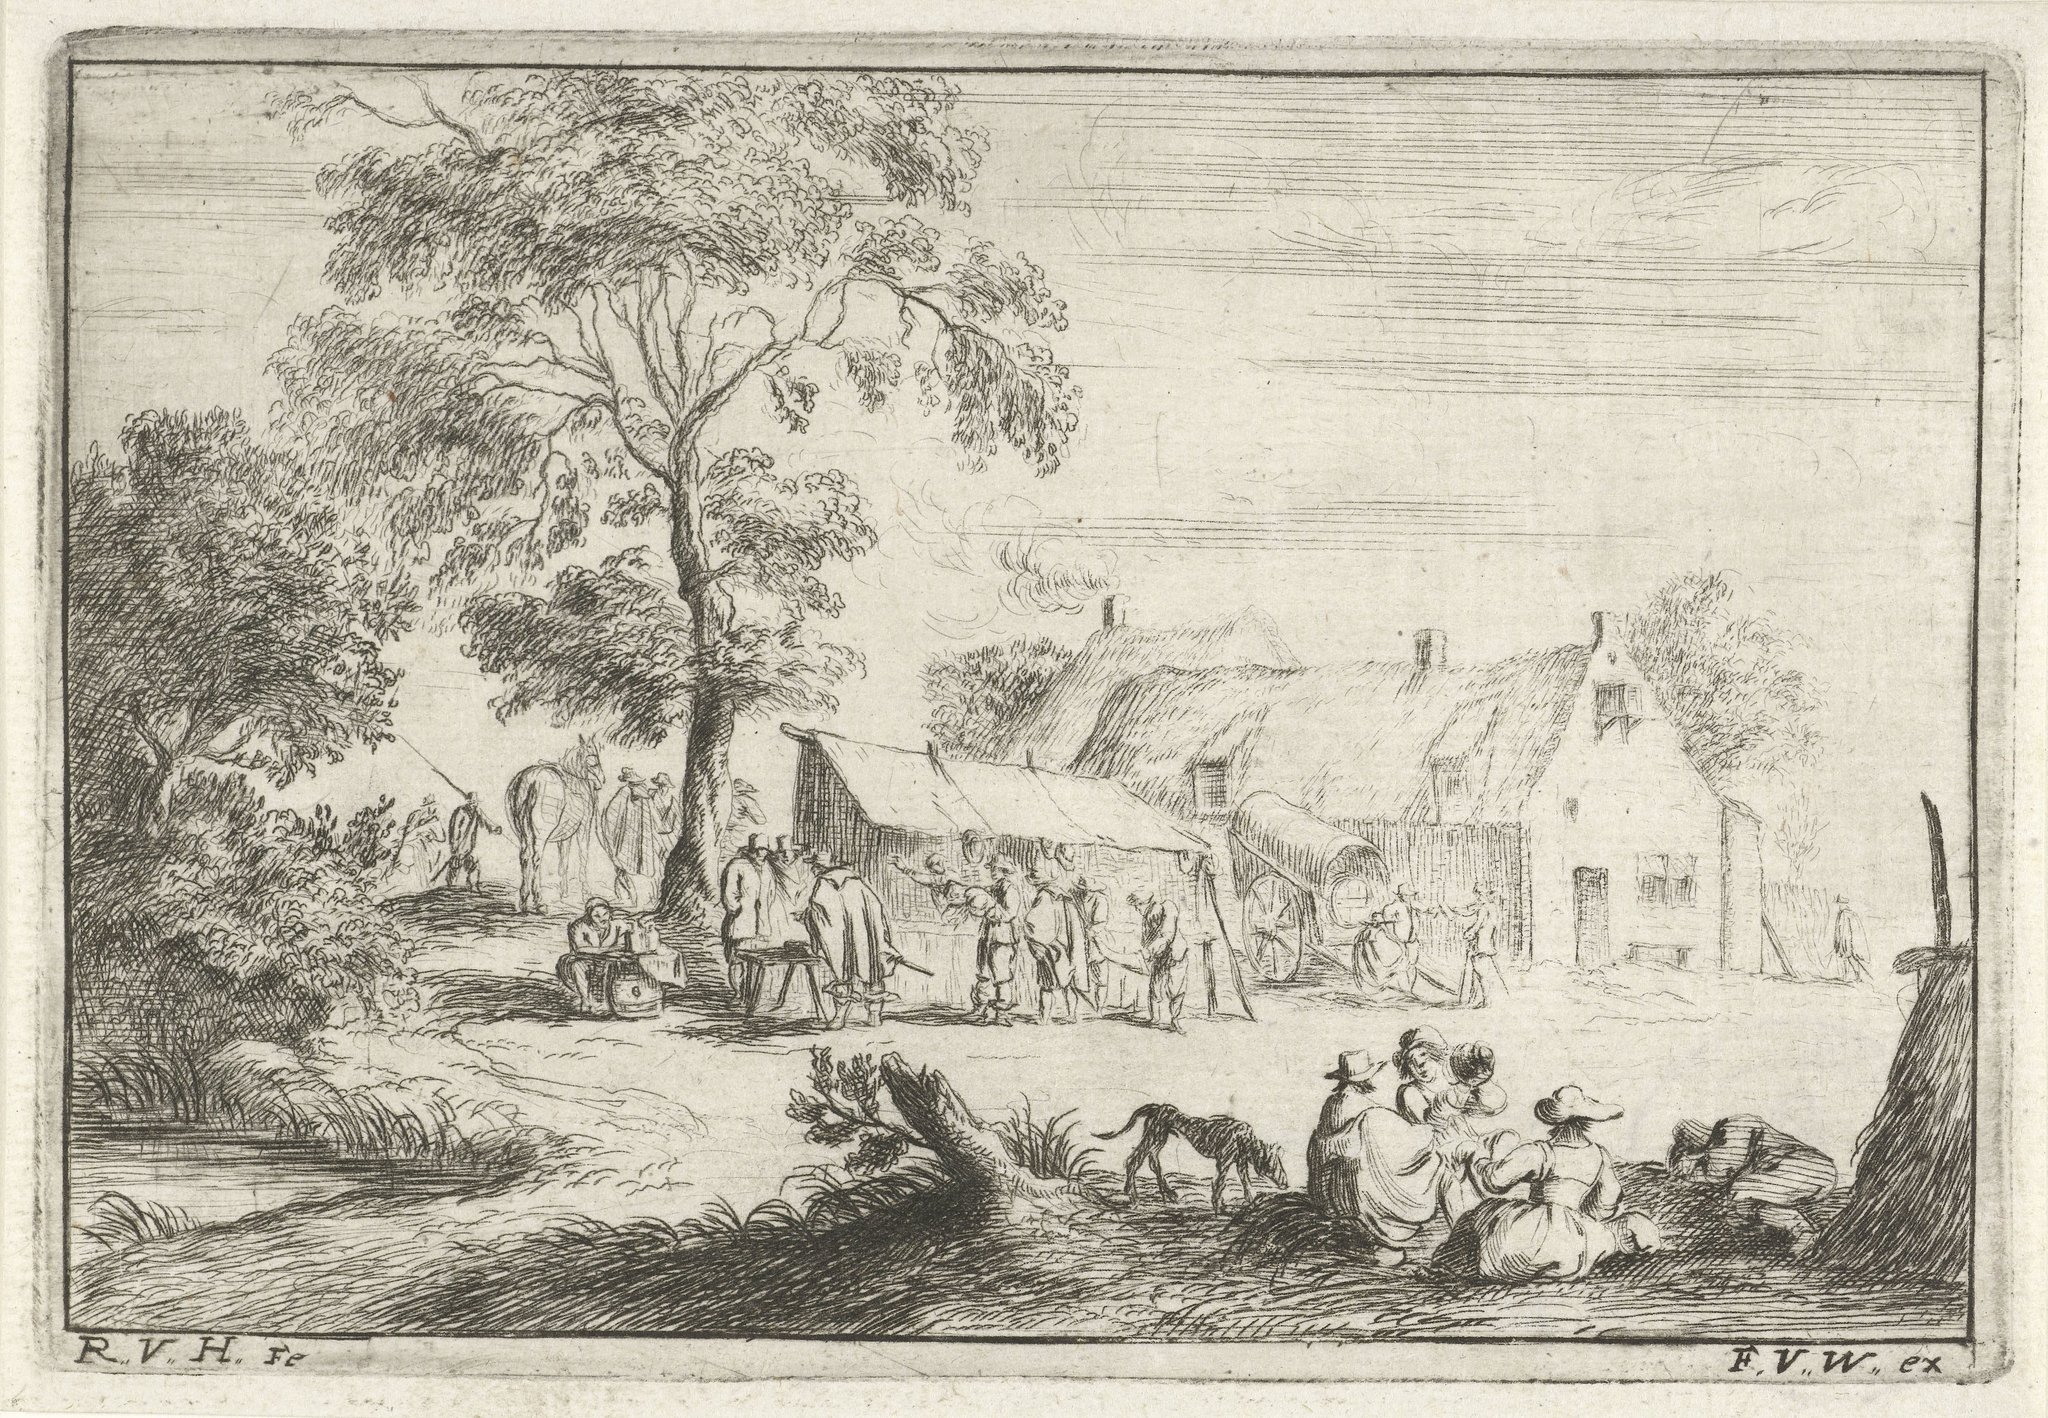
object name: print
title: Verschillende kampementen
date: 1632-1679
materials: paper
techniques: etching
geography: antwerp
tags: giving food, tent-camp, the soldier; the soldier's life, farm or solitary house in landscape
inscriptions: collector's mark: Lugt 240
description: Figuren bij een tent voor een boerderij waar voedsel wordt verkocht. Op de voorgrond een groep rustende figuren en een hond.